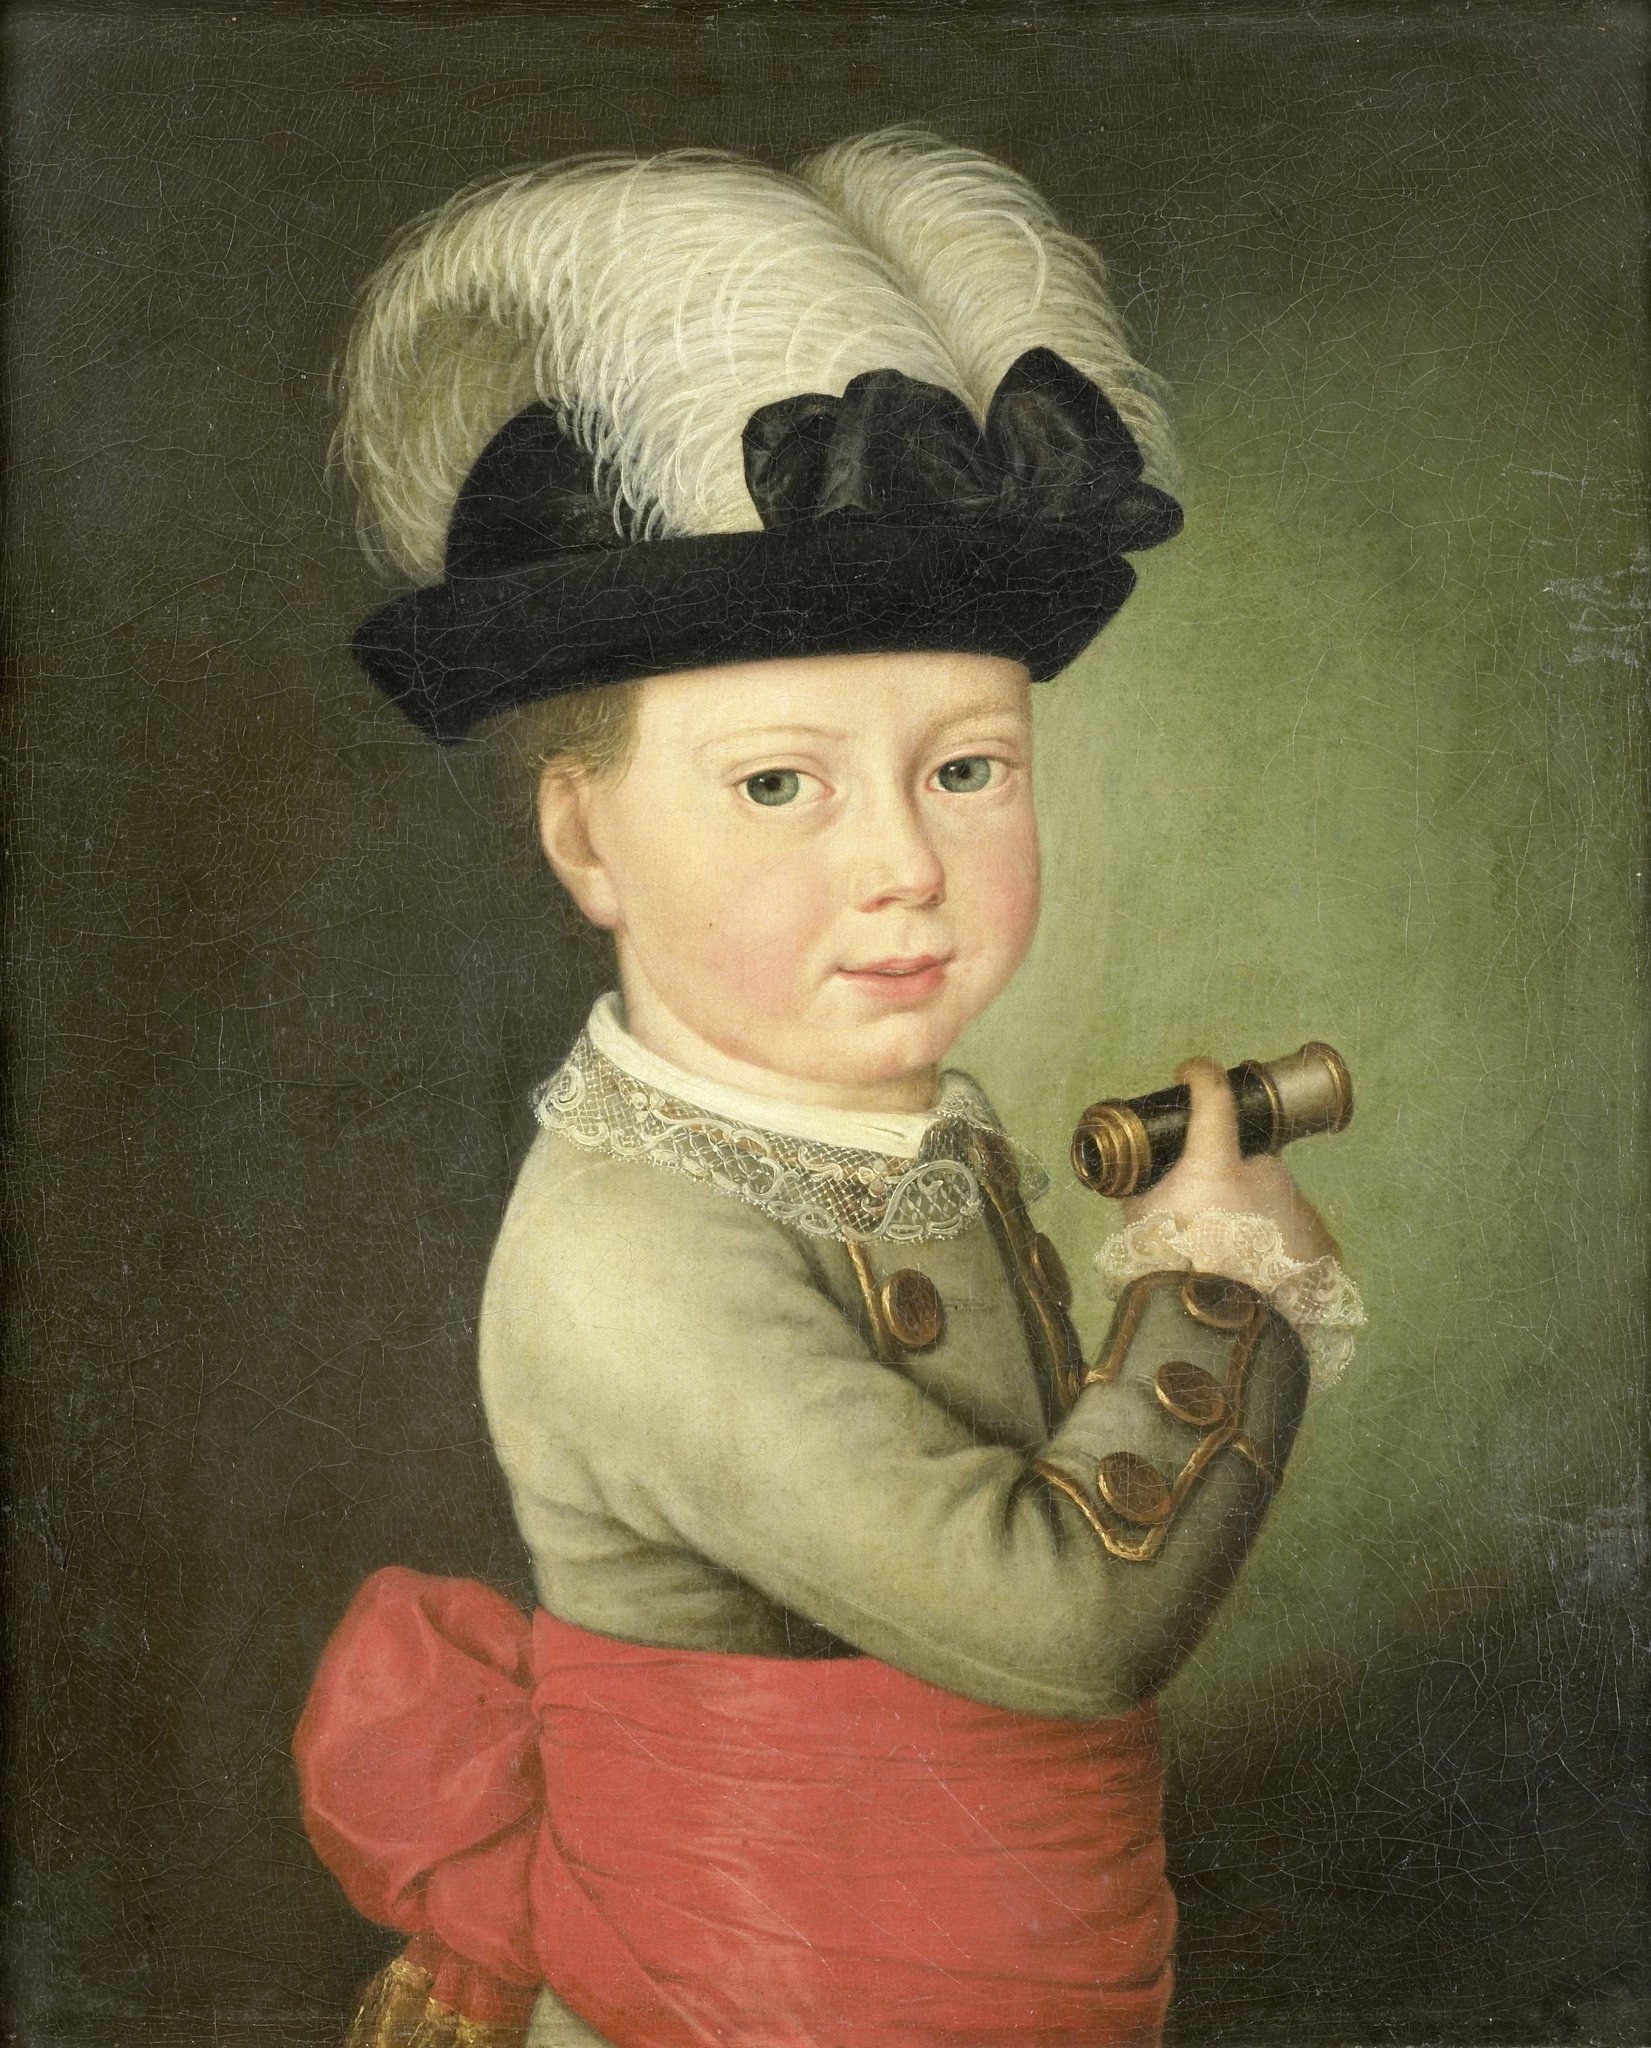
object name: painting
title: William George Frederick, Prince of Orange-Nassau, as a Child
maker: Anonymous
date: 1775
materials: canvas, oil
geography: northern netherlands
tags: willem george frederik (prins van oranje-nassau), historical persons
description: Portret van Willem George Frederik (1774-99), prins van Oranje-Nassau, als kind. Ten halven lijve naar rechts, in de rechterhand een kleine verrekijker, op het hoofd een hoed met witte pluim. Pendant van SK-A-1476.